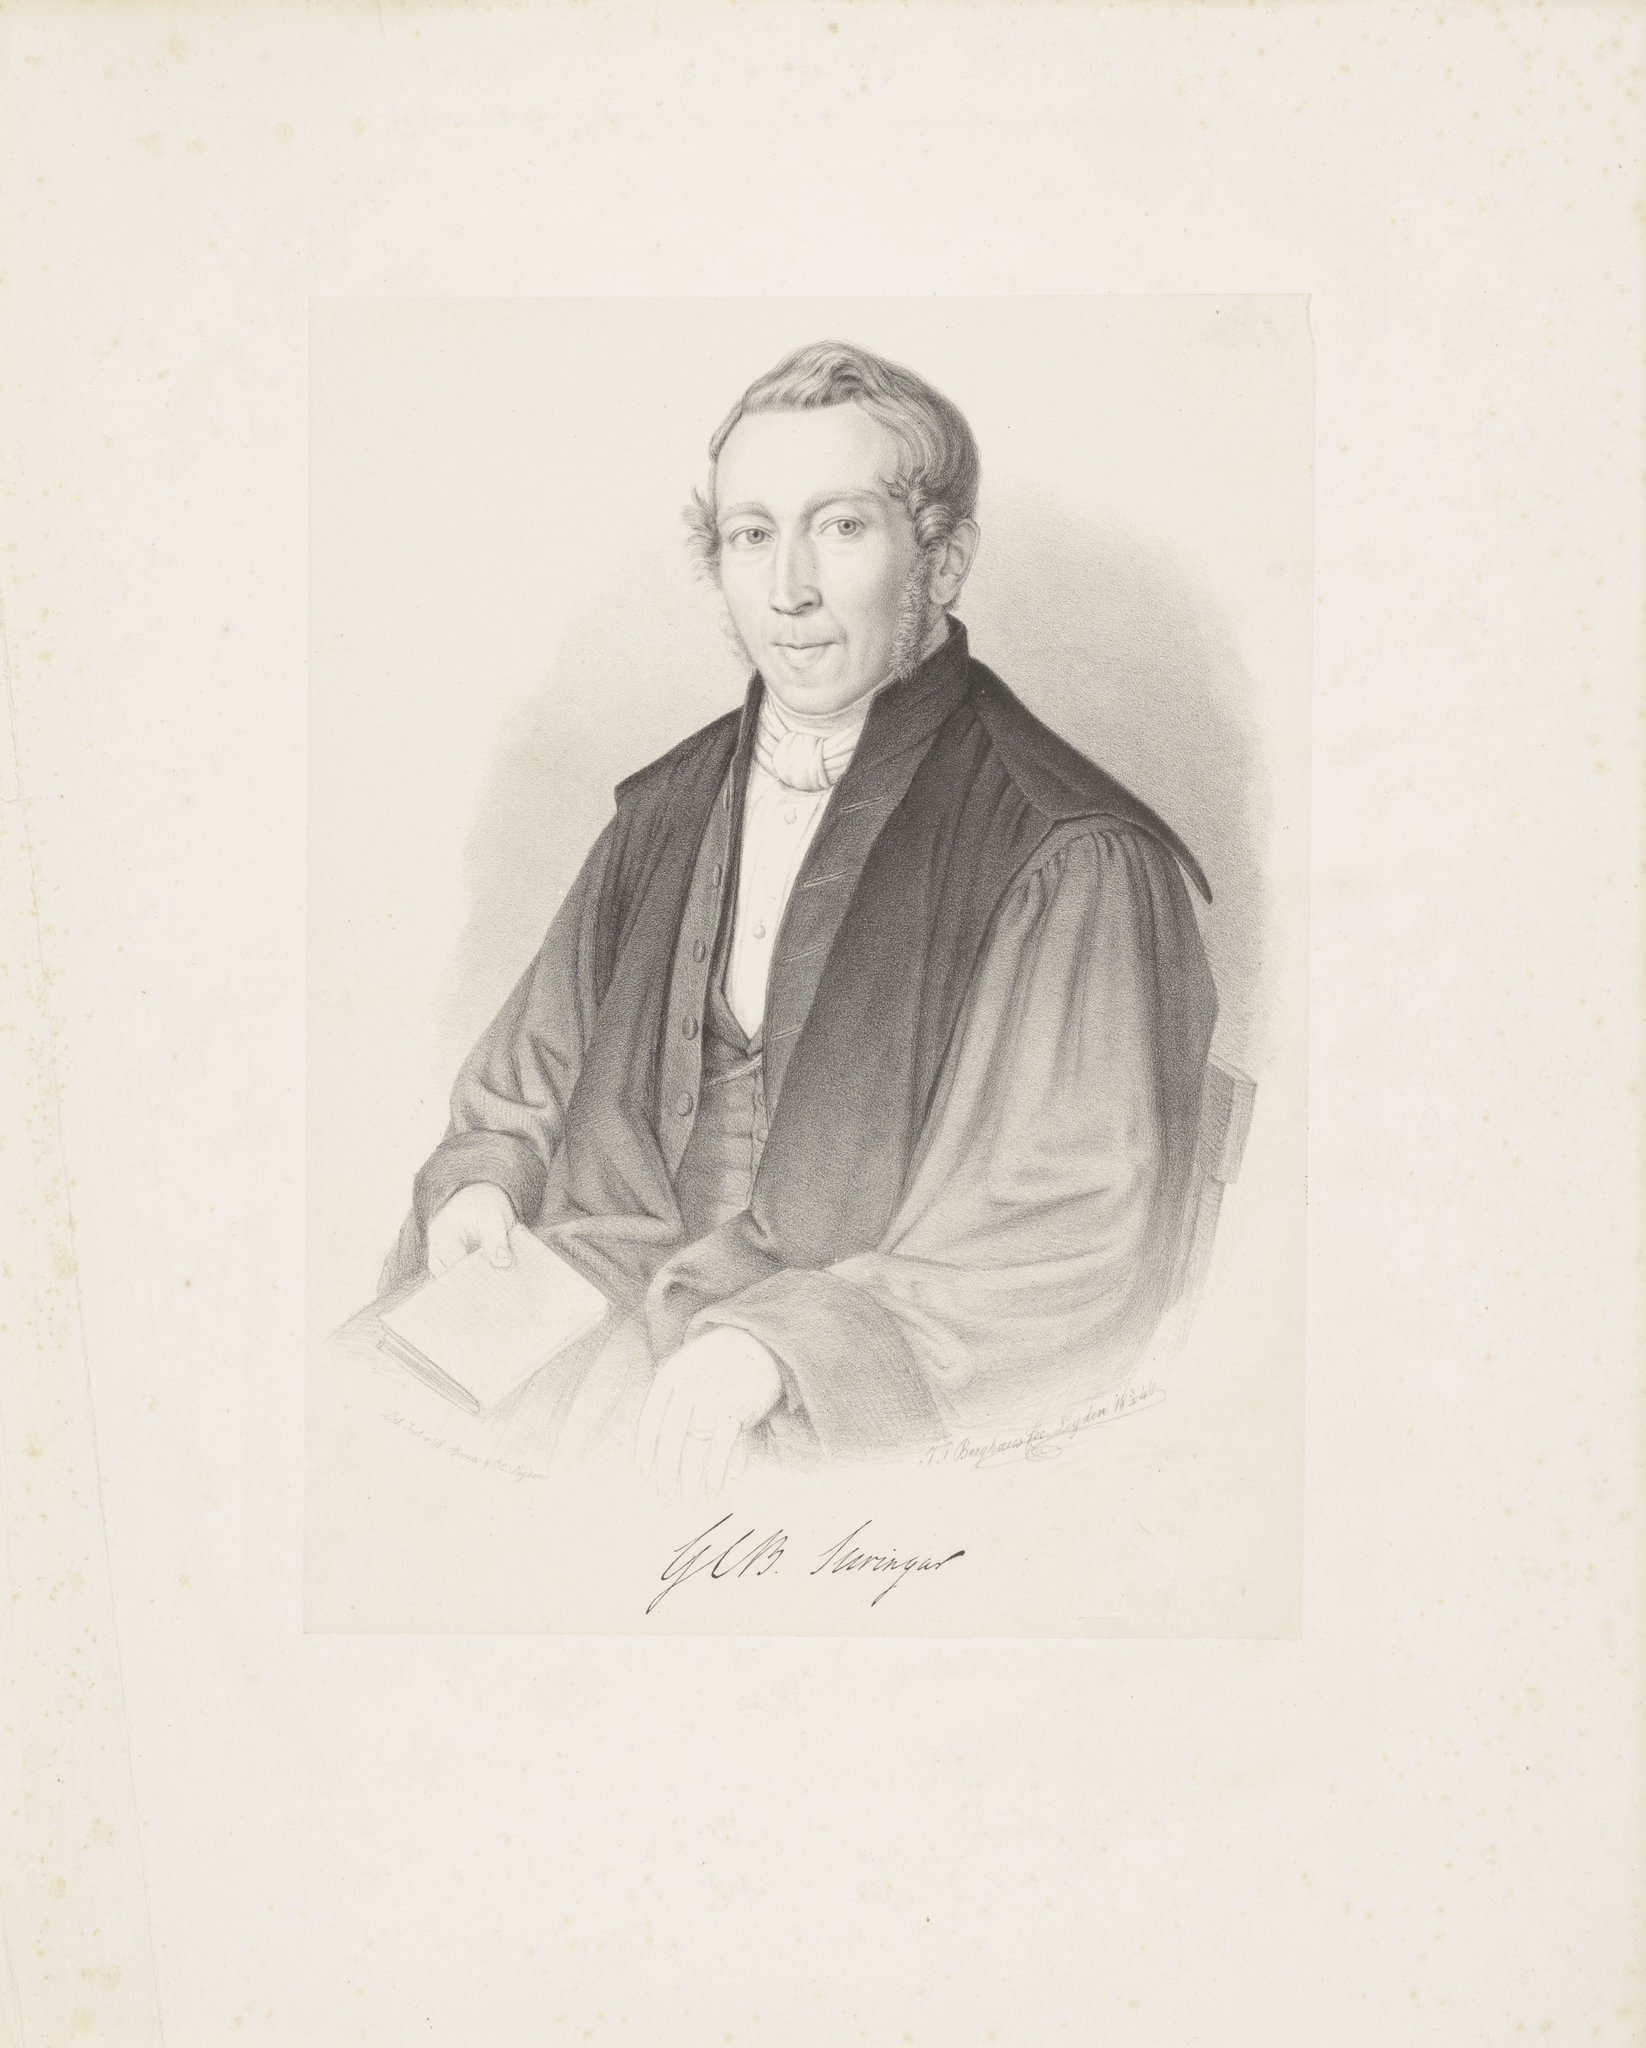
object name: print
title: Portret van Gerard Conrad Bernard Suringar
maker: johann peter berghaus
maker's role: print maker, printer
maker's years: 1810-1870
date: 1846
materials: paper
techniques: lithograph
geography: leiden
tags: leiden, historical persons, book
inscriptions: collector's mark: Lugt 2228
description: De geportretteerde draagt een toga en heeft een boek in zijn rechterhand. Onder het portret zijn signatuur.